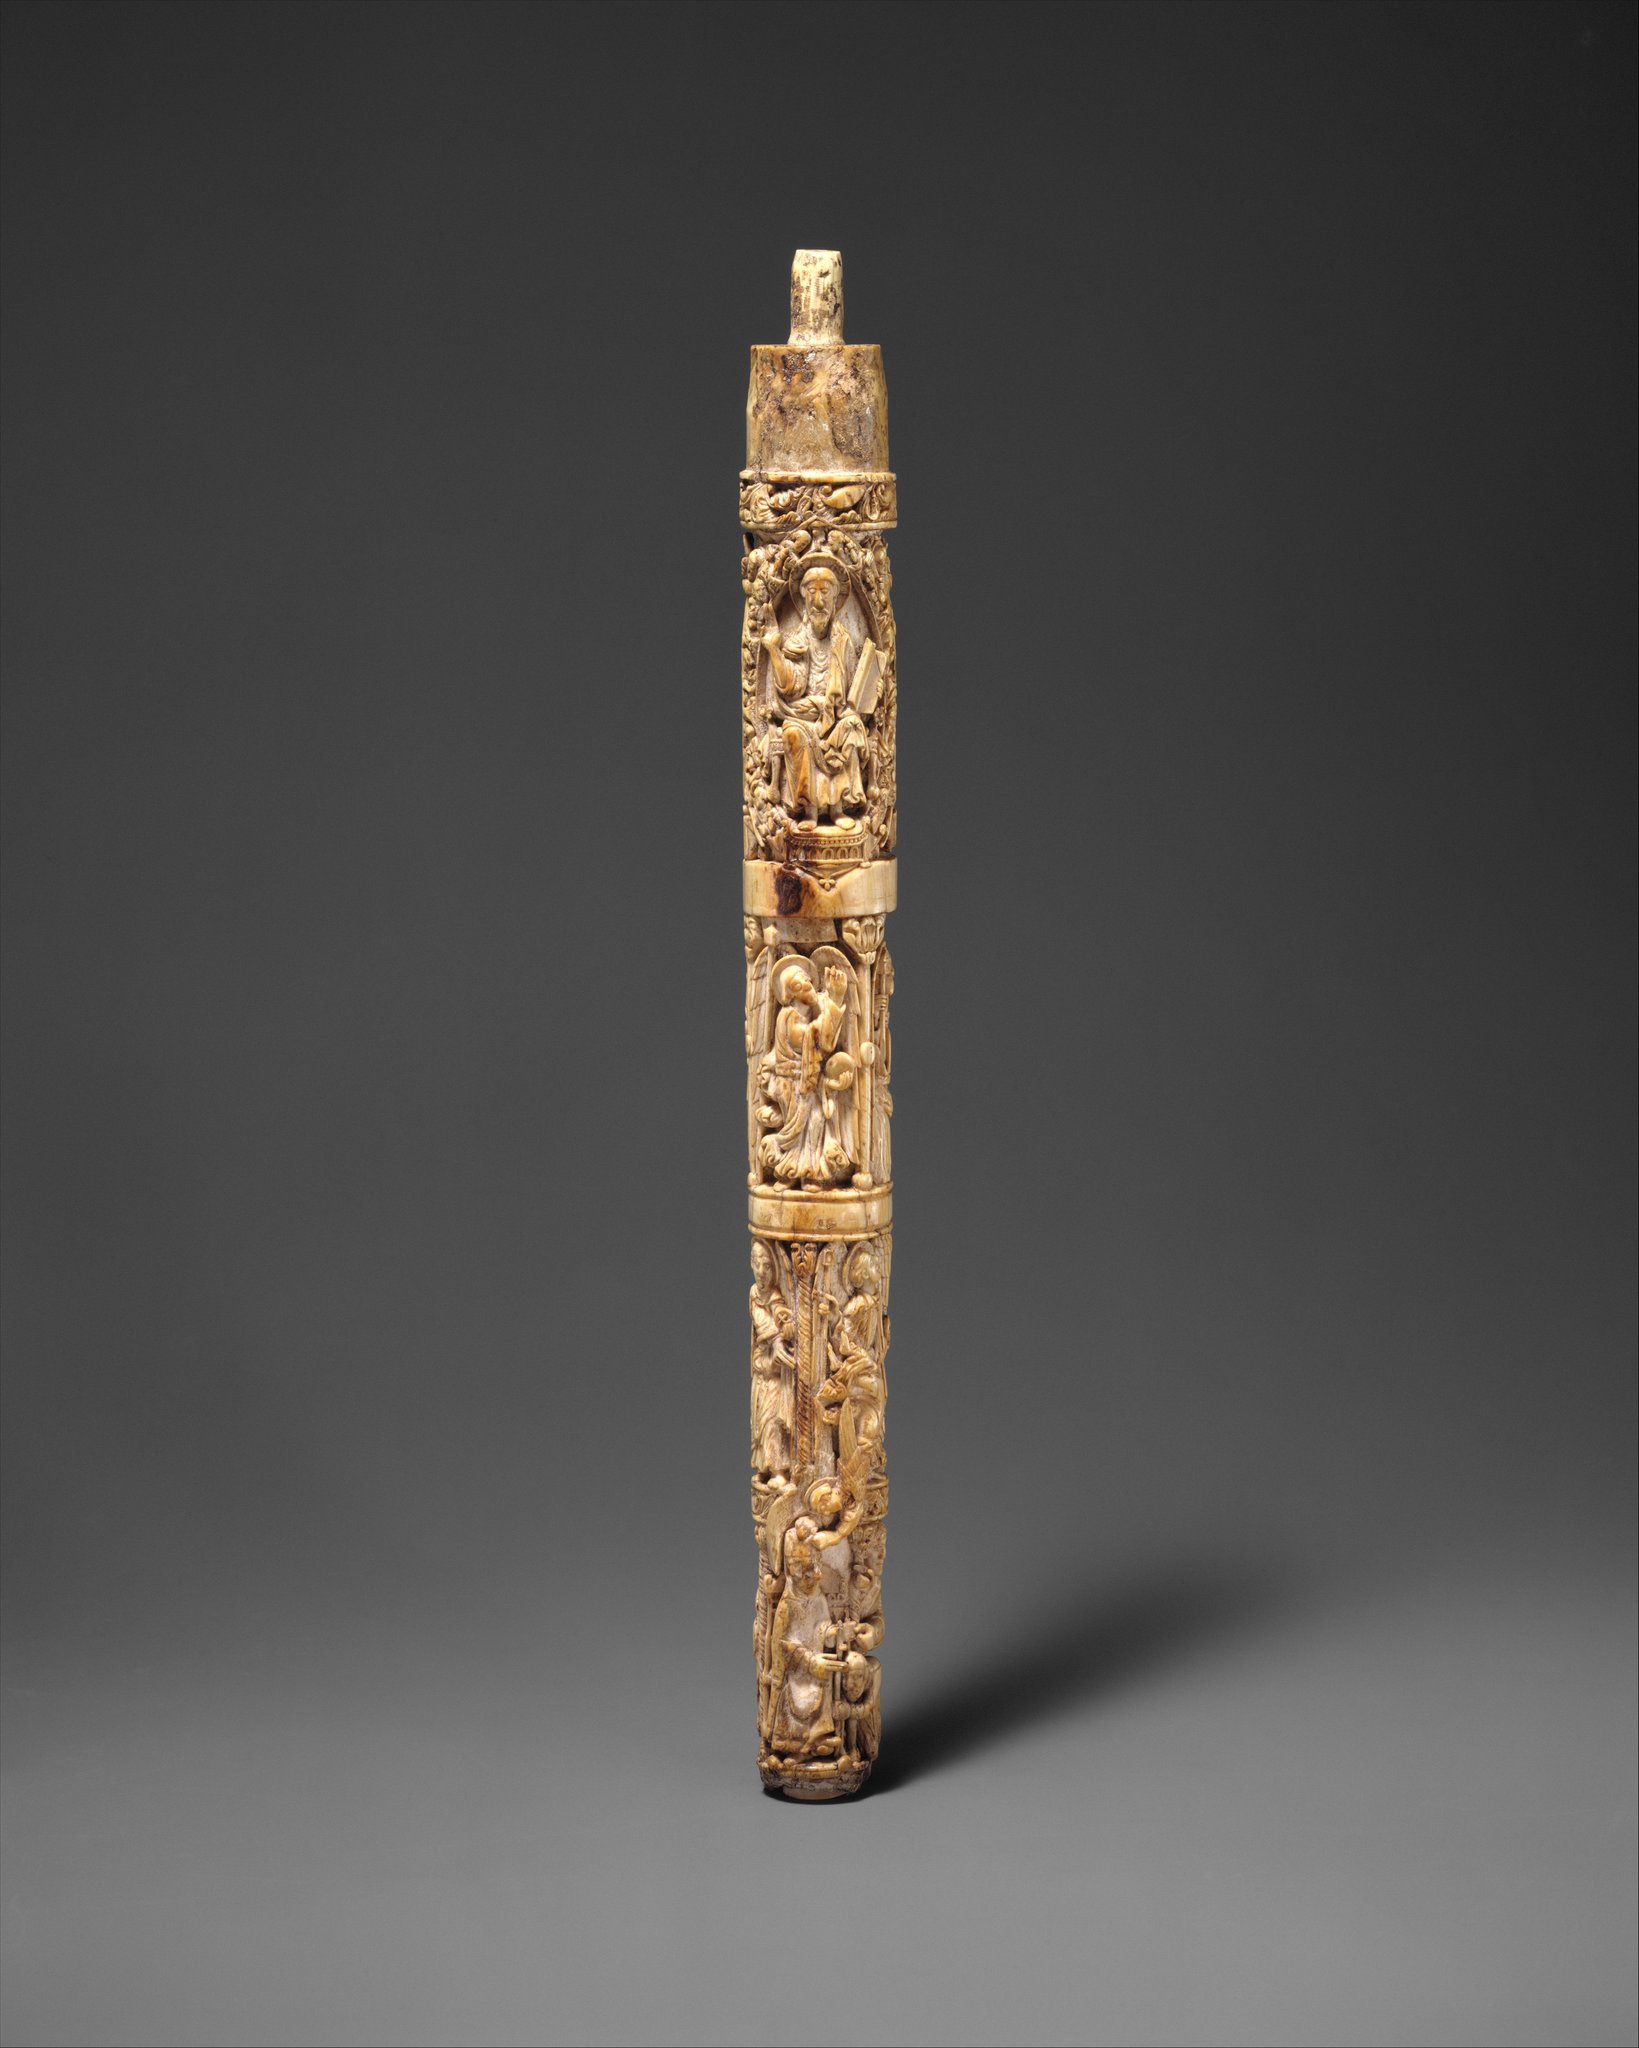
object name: crozier stem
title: Segment of a Crozier Shaft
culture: spanish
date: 1167-1200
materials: ivory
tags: angels,bishops,christ,virgin mary